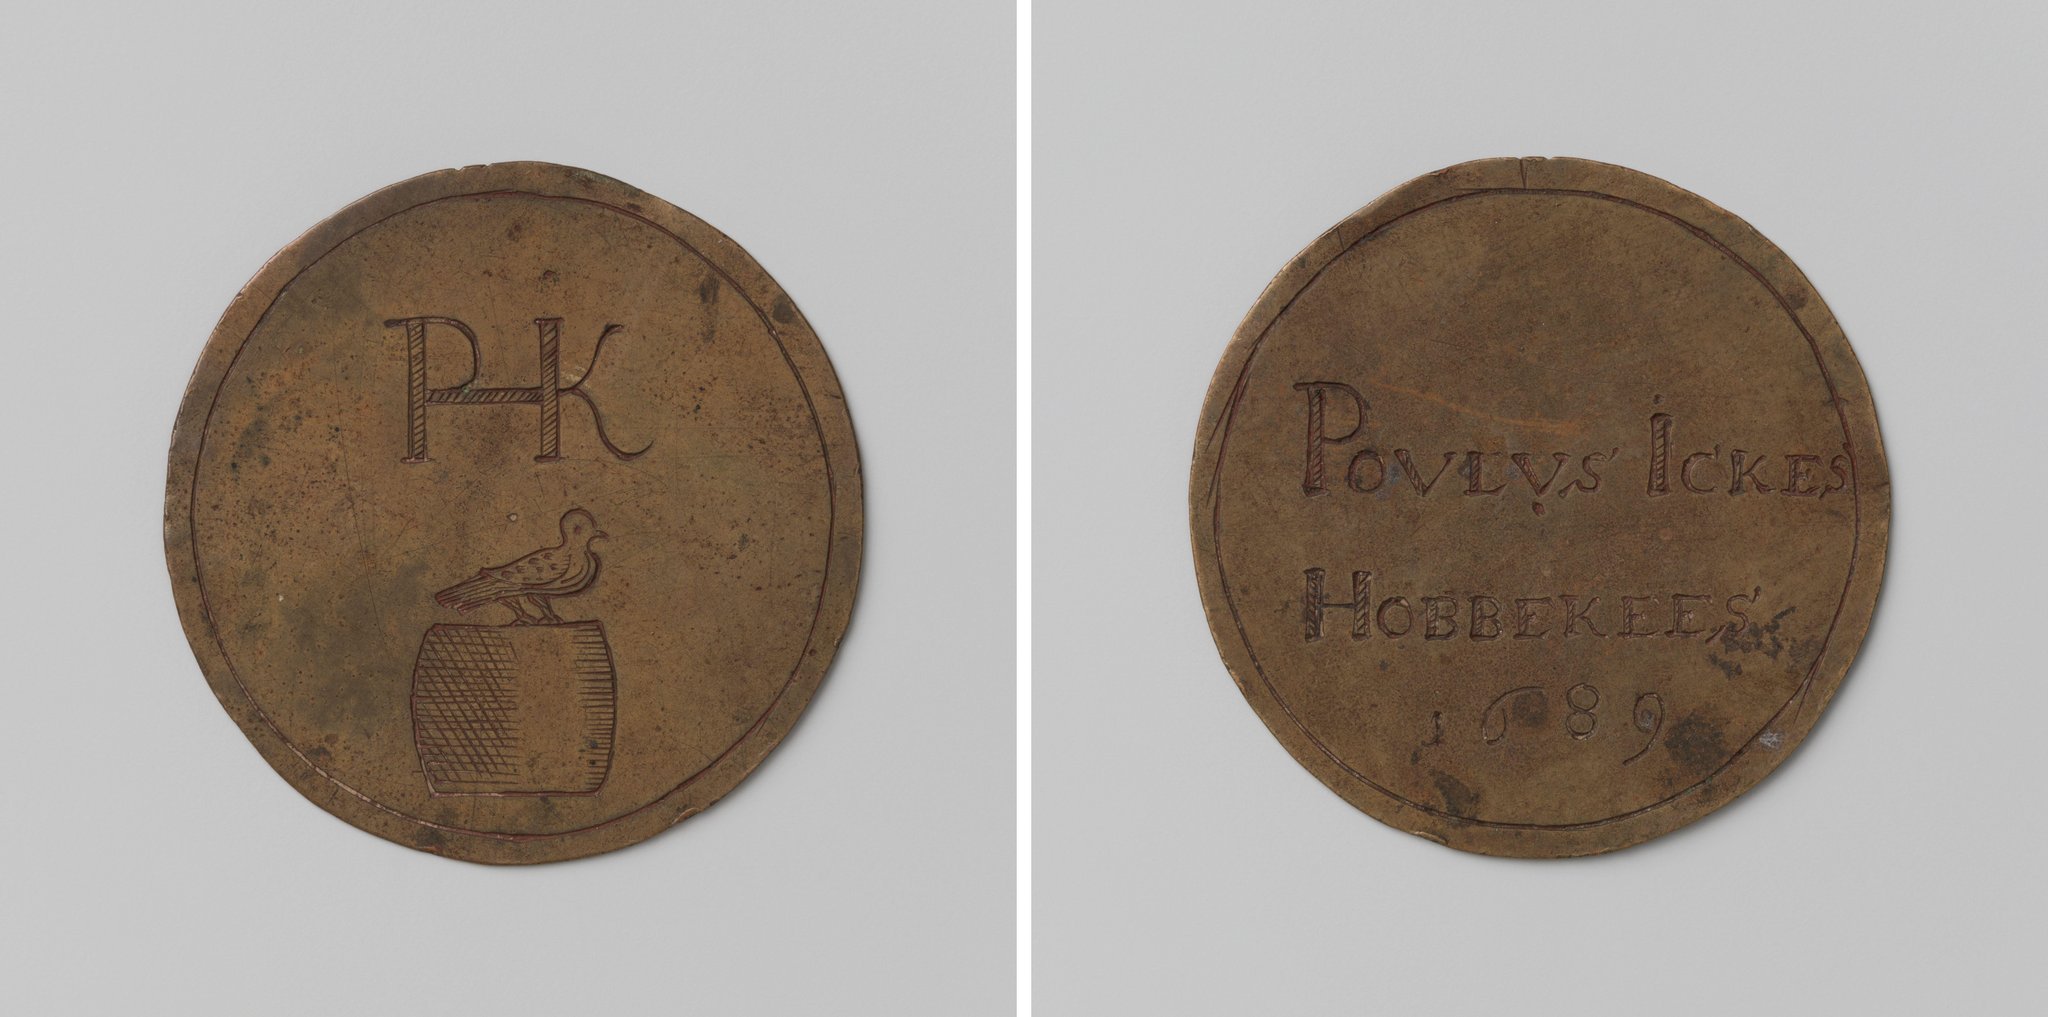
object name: medal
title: Gildepenning van Poulus Ickes Hobbekees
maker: Anonymous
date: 1689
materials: brass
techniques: engraving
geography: netherlands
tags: harlingen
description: Messing penning. Voorzijde: vogel, zittend op ton onder monogram van letters P, H en K. Keerzijde: opschrift. Een onbekend gilde.